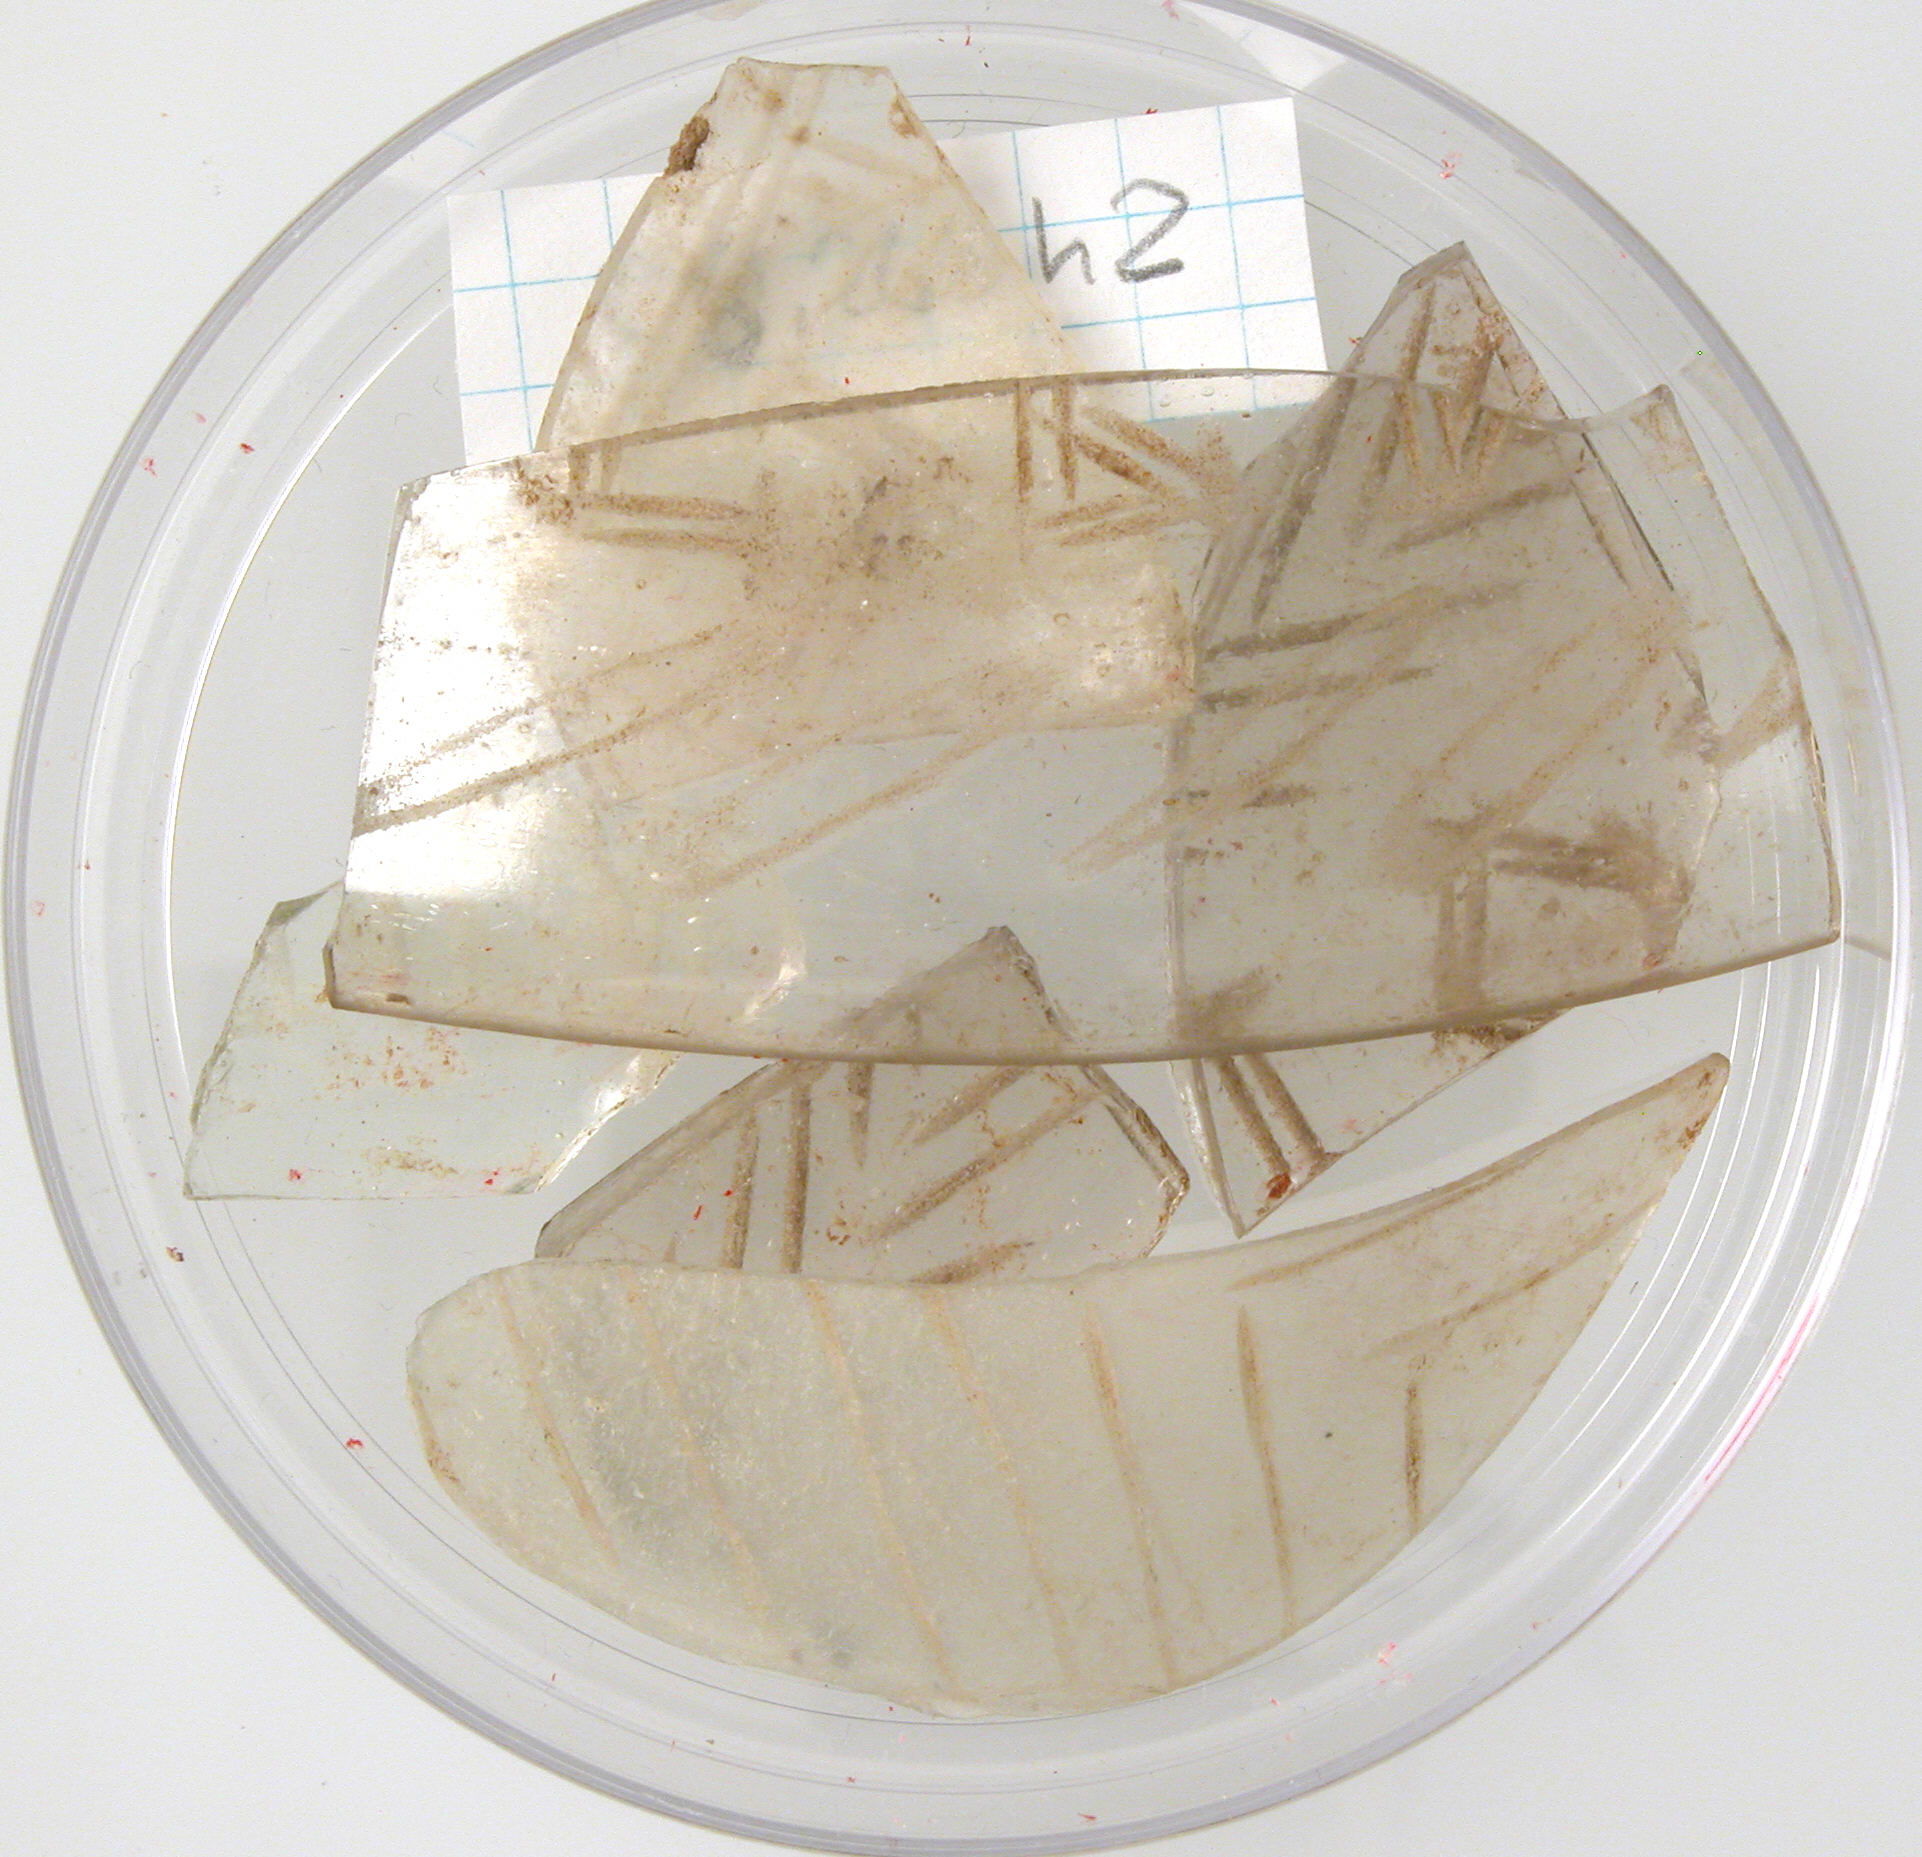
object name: fragment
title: Glass Fragments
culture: coptic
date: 301-433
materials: glass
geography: egypt